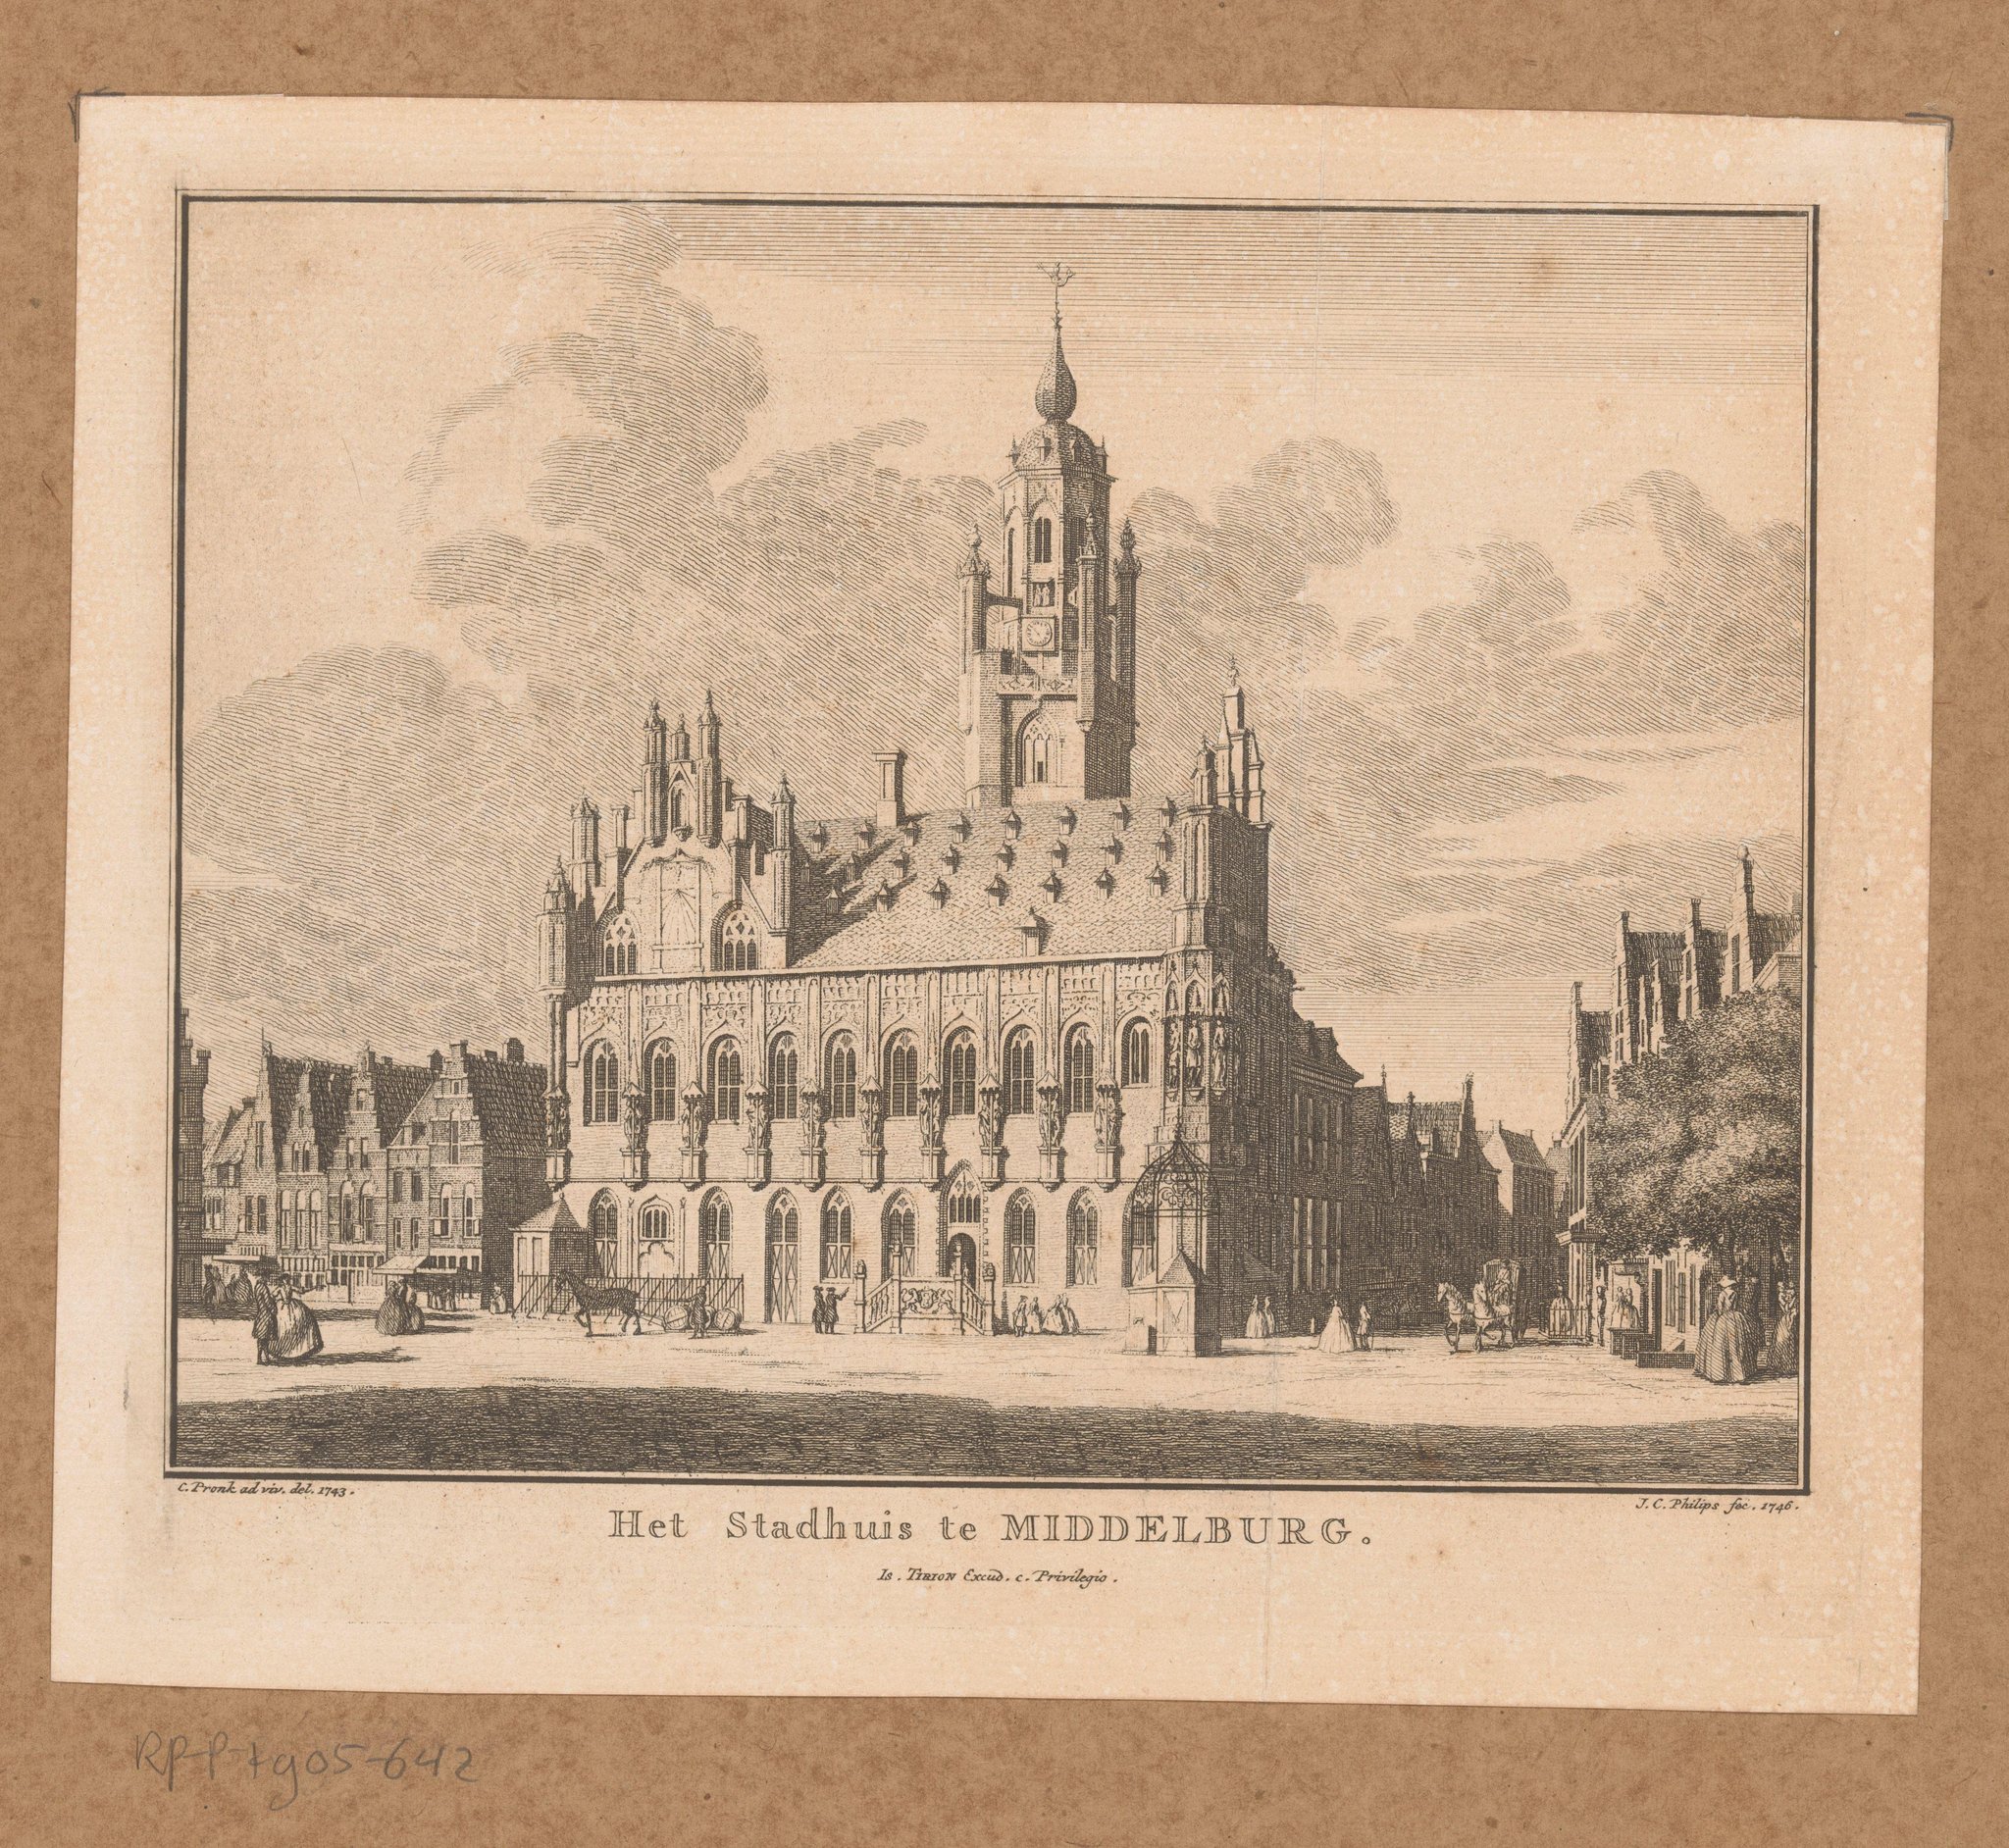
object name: print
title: Het stadhuis te Middelburg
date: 1746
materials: paper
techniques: etching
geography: amsterdam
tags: townhall, square, place, circus, etc. (+ city(-scape) with figures, staffage)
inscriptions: collector's mark: Lugt 2228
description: Prent ook gebruikt in: Boddaert, Pieter et al. Tegenwoordige staat der Vereenigde Nederlanden (...). Amsterdam: Isaak Tirion, 1751, dl. 9. Zie RP-P-AO-15-161-3 voor proefdruk.